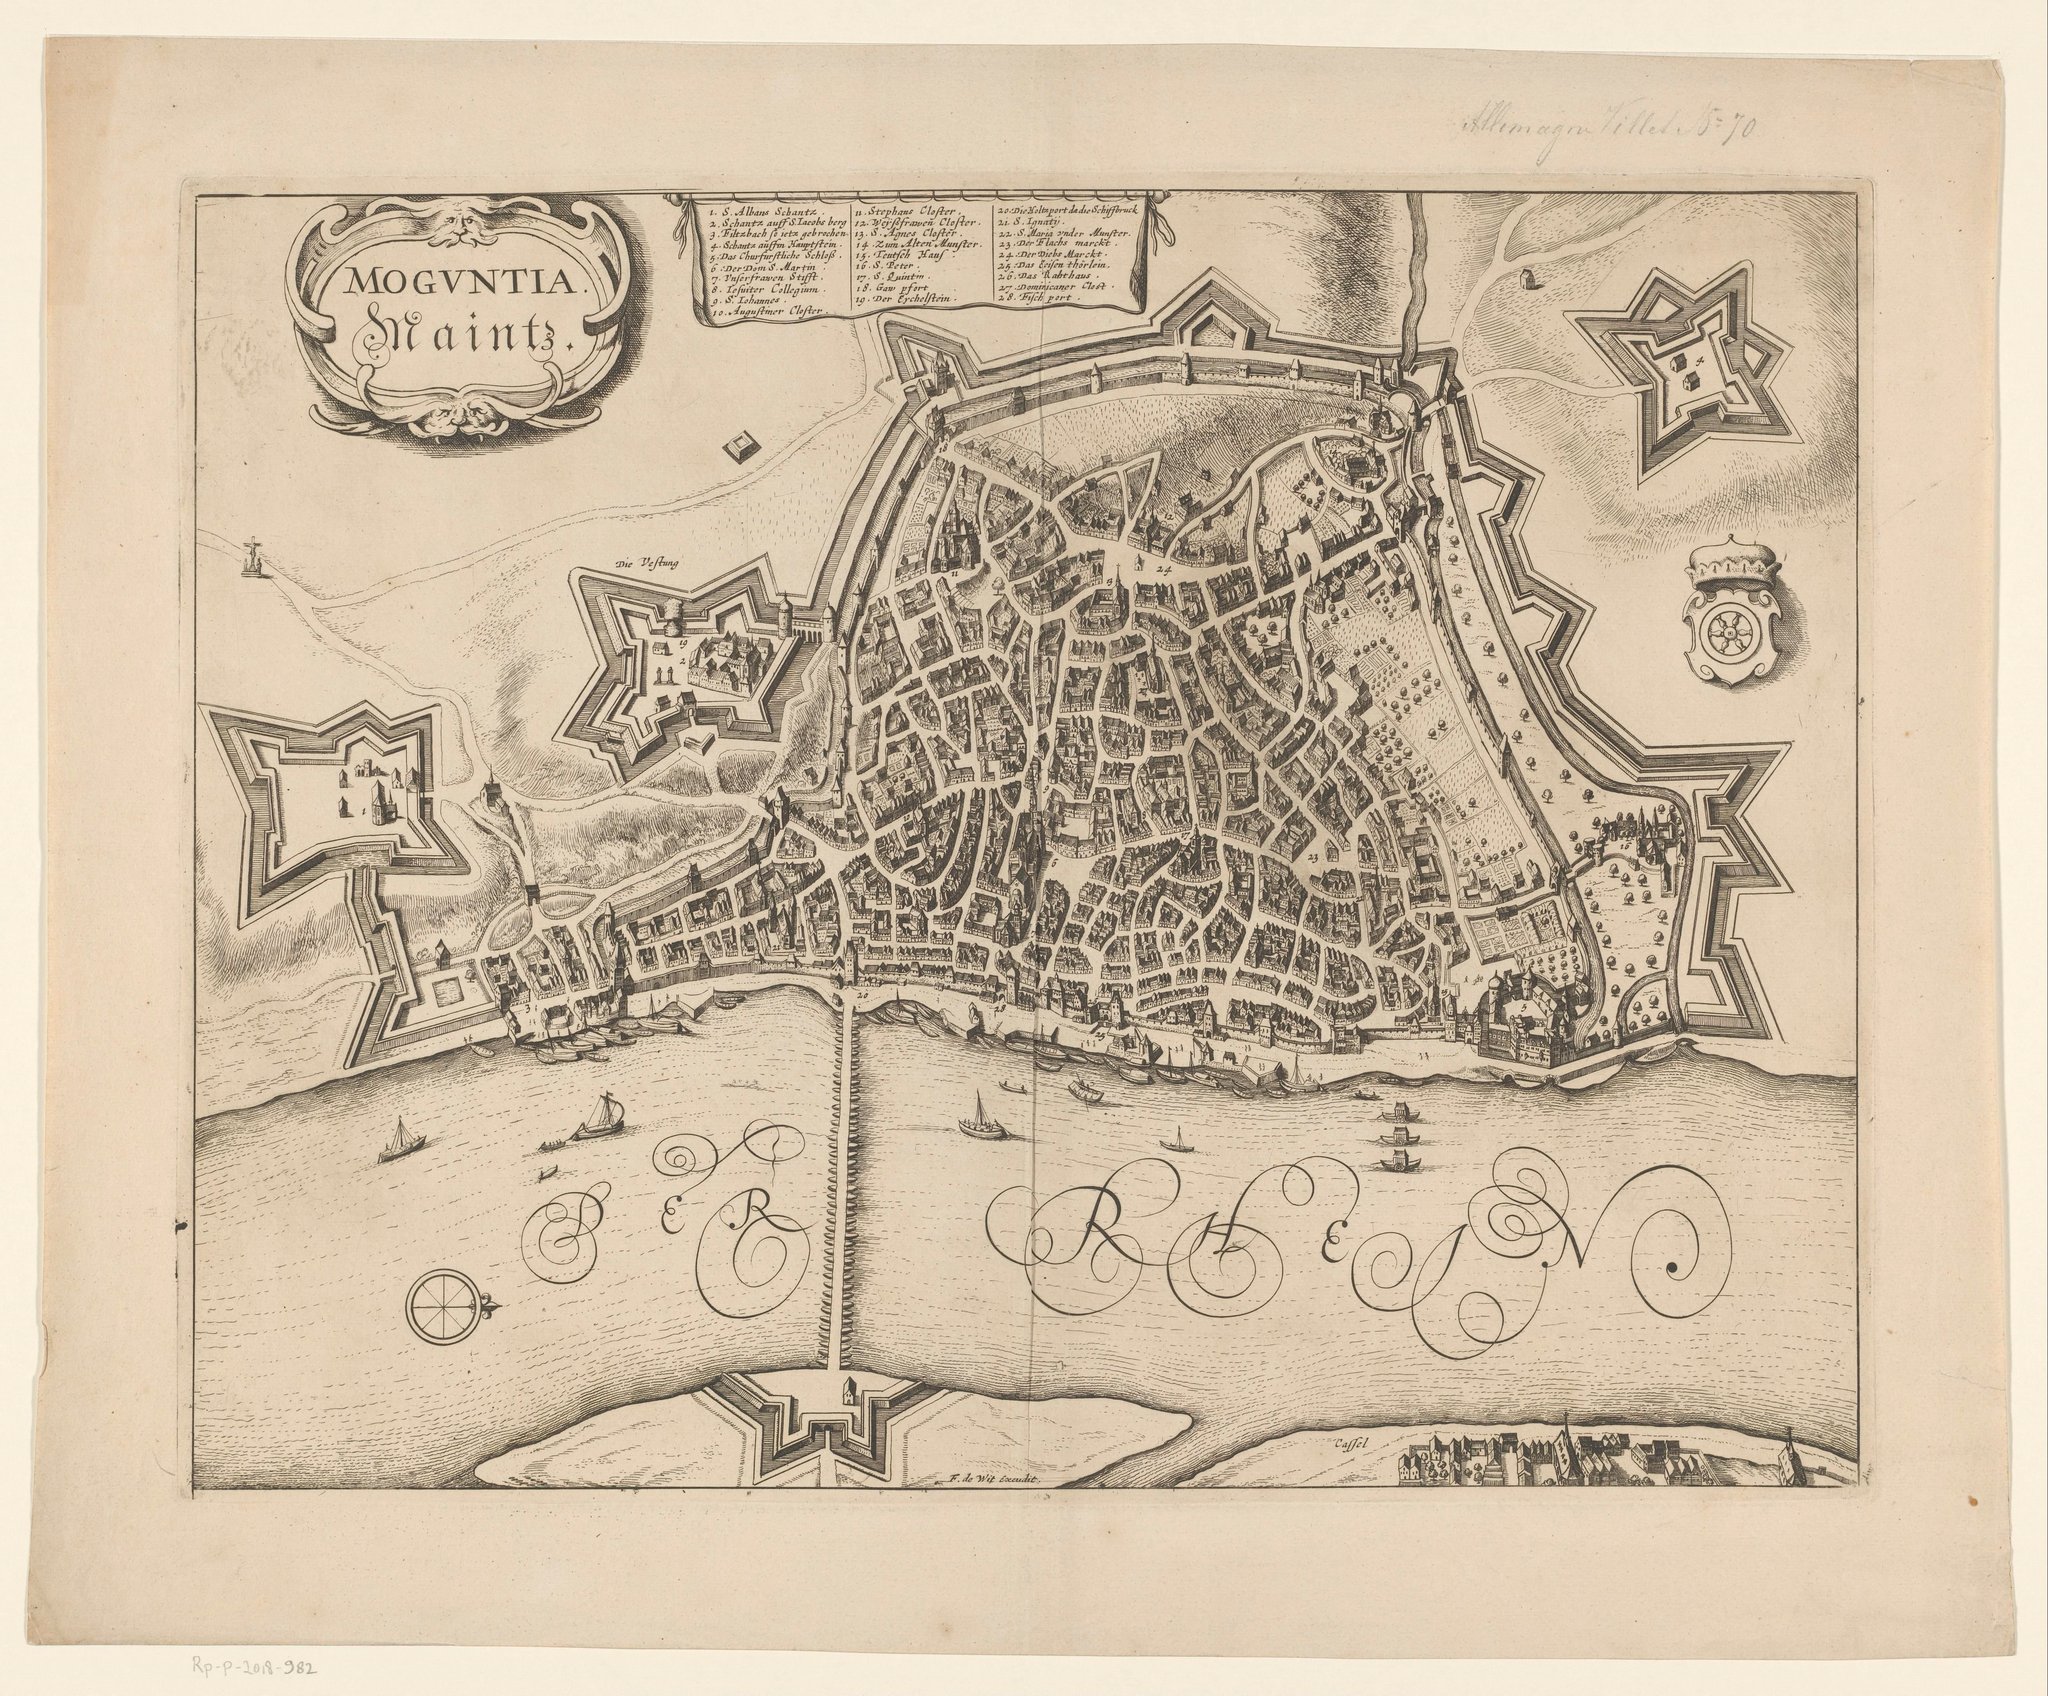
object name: area plan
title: Plattegrond van Mainz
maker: Anonymous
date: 1657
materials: paper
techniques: engraving, etching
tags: coat of arms (as symbol of the state, etc.) (+ city; municipal), maps of cities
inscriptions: collector's mark: Lugt 2228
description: Plattegrond van Mainz met gebouwen in vogelvluchtperspectief. Rechtsboven een wapenschild met het Rad van Mainz.